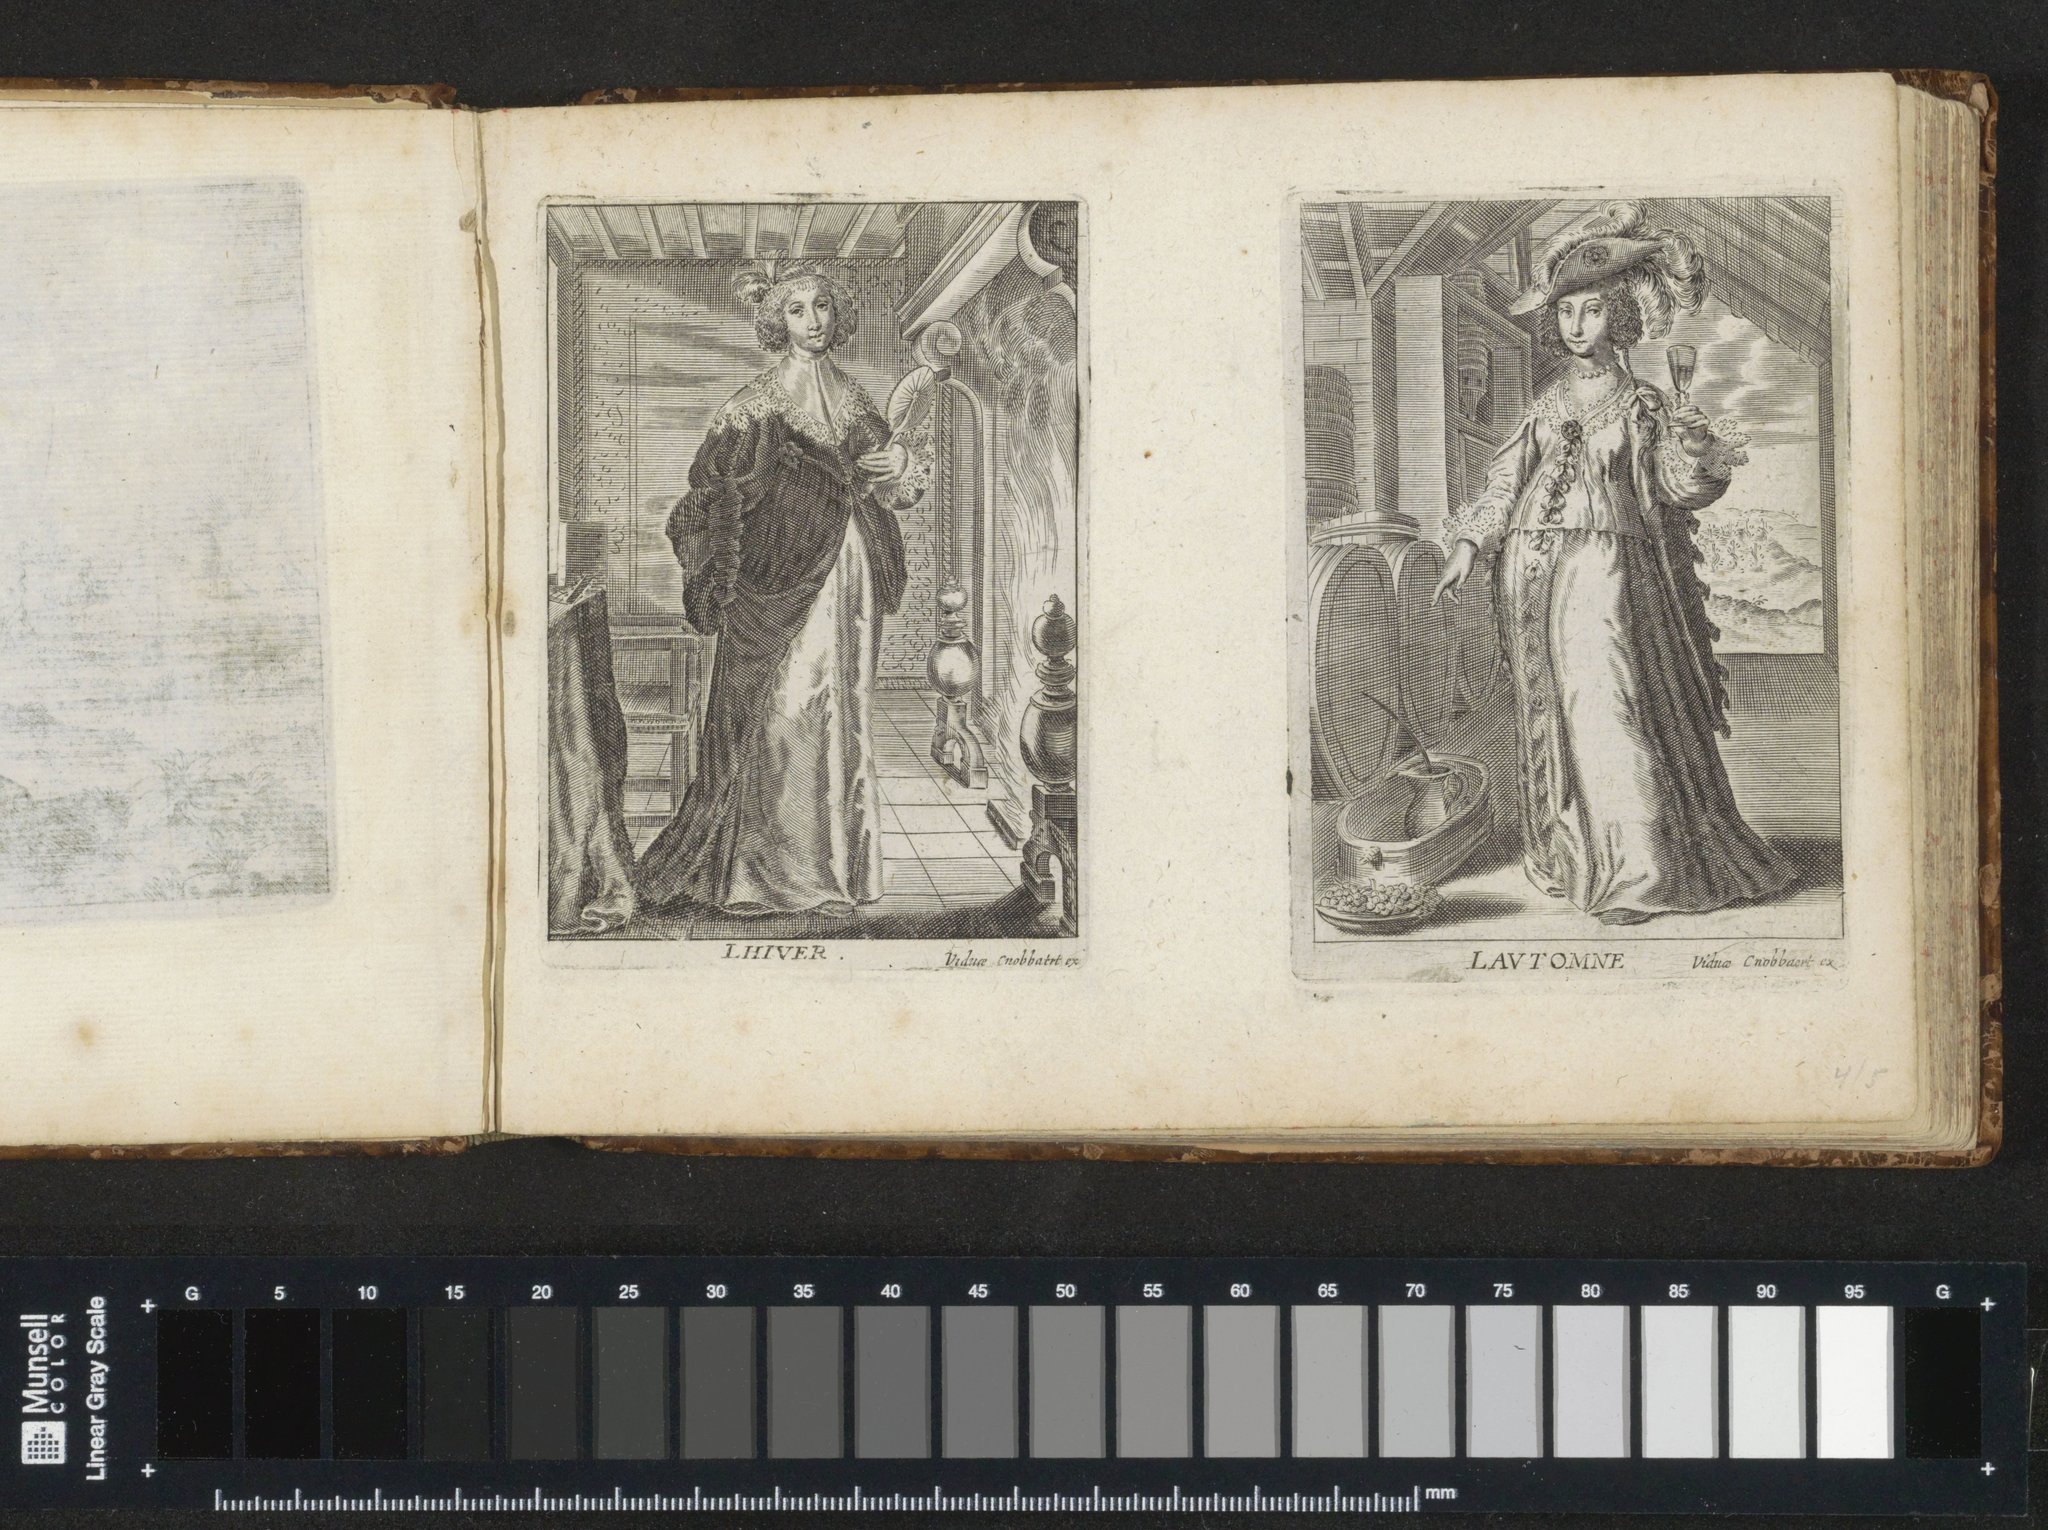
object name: album leaf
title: De vier seizoenen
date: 1637-1671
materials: paper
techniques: engraving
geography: antwerp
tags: autumn, fall, 'autumnus'; 'autunno' (ripa)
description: Een vrouw met hoed met veren op het hoofd staat met een glas wijn in haar hand in een schuur met wijnvaten. Ze wijst op een schaal met een tros druiven. Ze is de personificatie van het seizoen van de herfst. Deze prent maakt deel uit van een album.